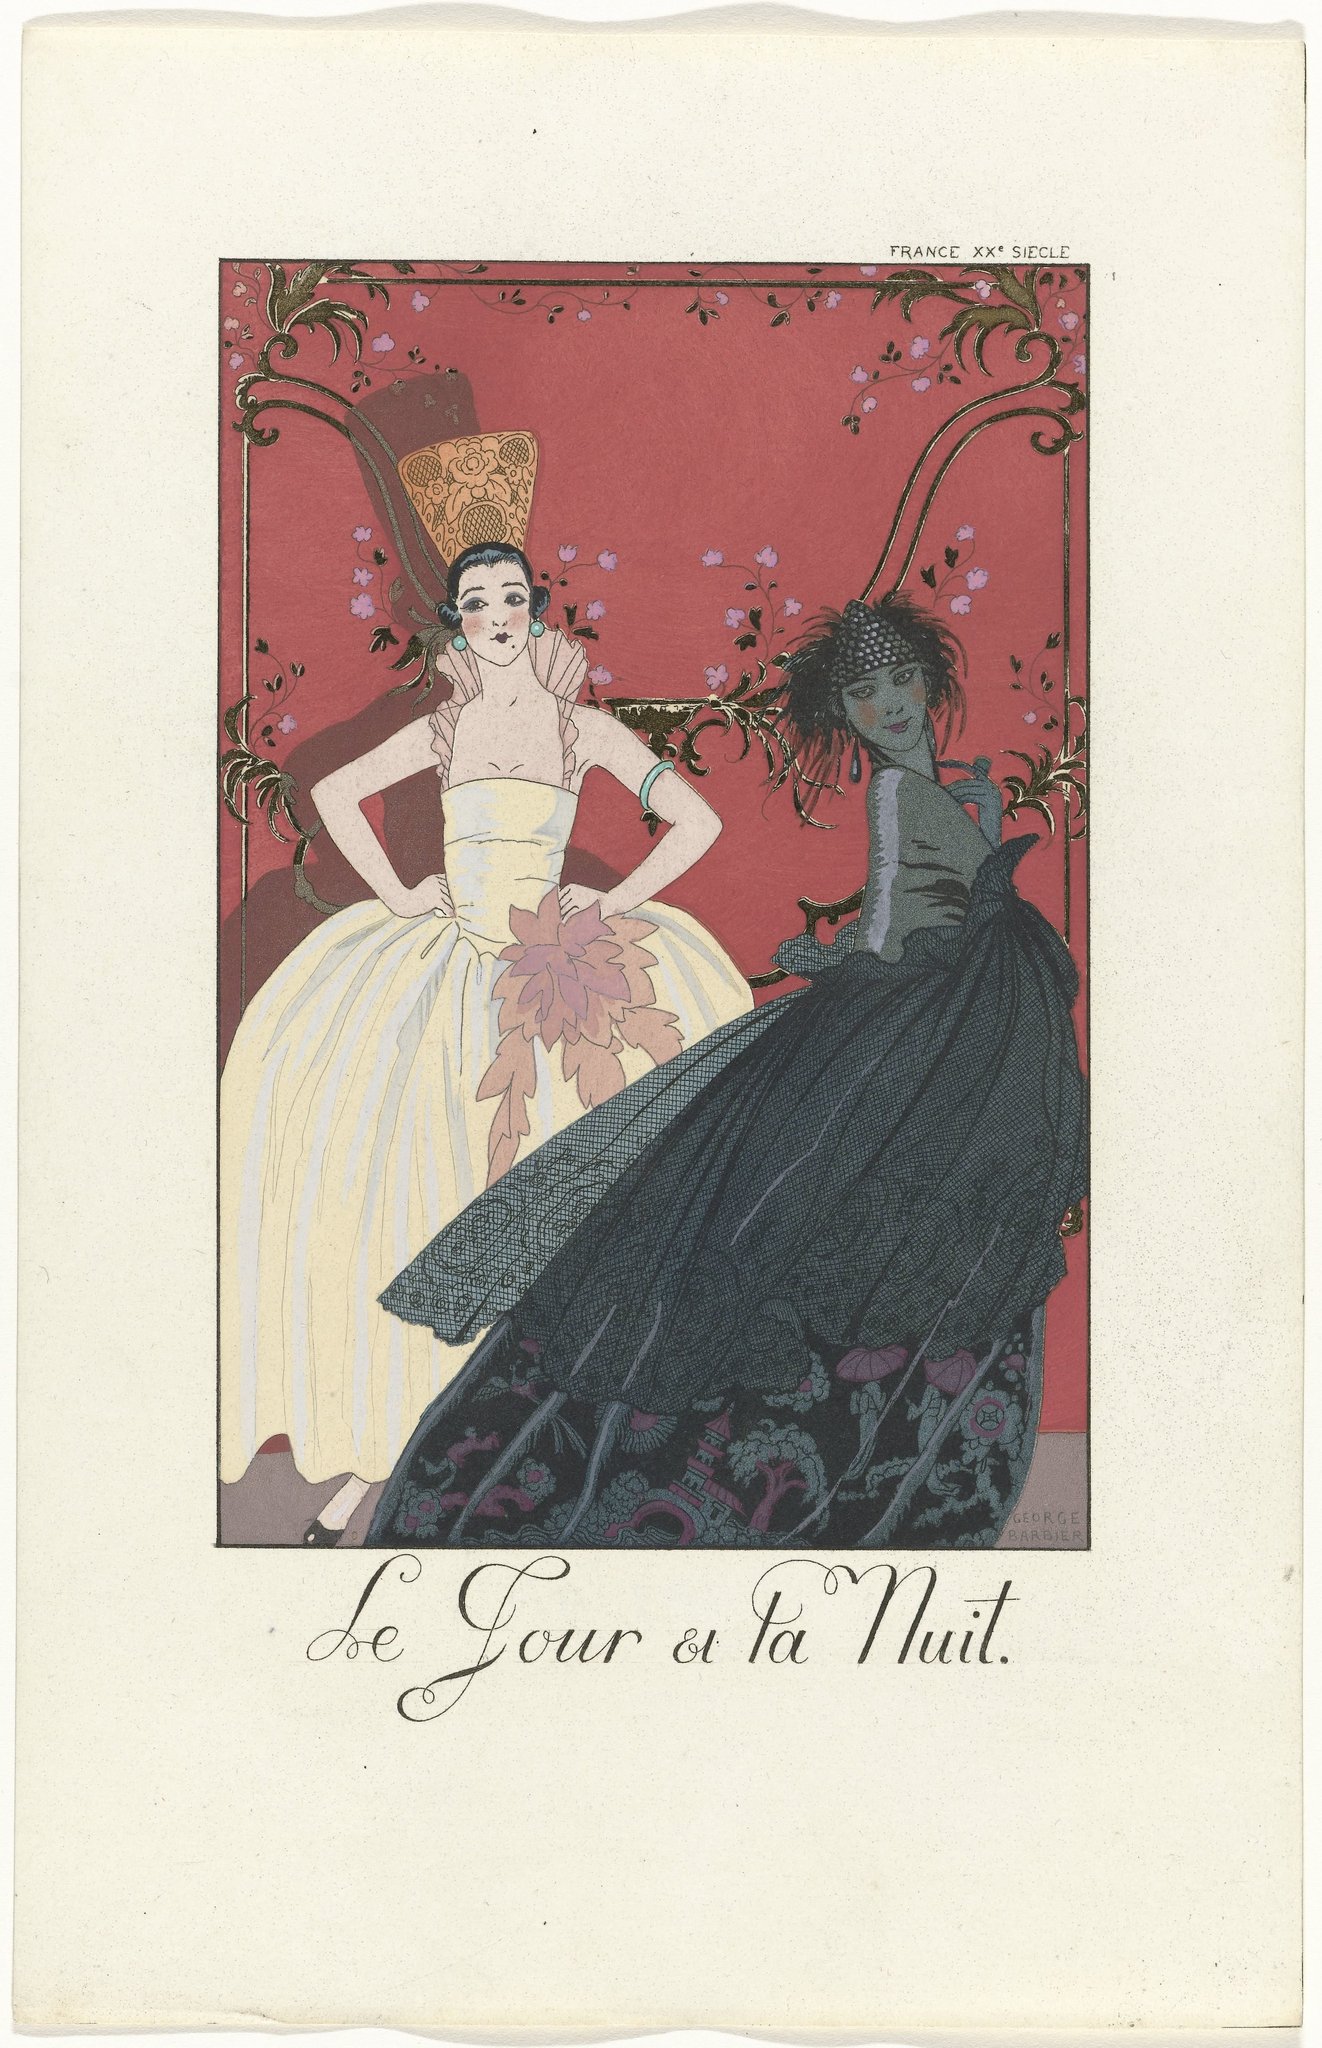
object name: fashion print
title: Falbalas et Fanfreluches: almanach des modes présentes, passées & futures pour 1922: Le Jour et la Nuit / France XXe siècle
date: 1922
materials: paper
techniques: hand coloring, lithograph, pochoir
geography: paris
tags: ear-rings (+ women's clothes), dress, gown: evening dress (+ women's clothes), coat (+ women's clothes), fashion plates, skirt (+ women's clothes)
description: Twee vrouwen tegen een rode achtergrond. De voorste is gekleed in een zwarte avondjapon en verbeeldt de nacht. De achterste in een witte avondjapon, met tulband op het hoofd, verbeeldt de dag. Prent uit de serie Falbalas & Fanfreluches (1922-1926).